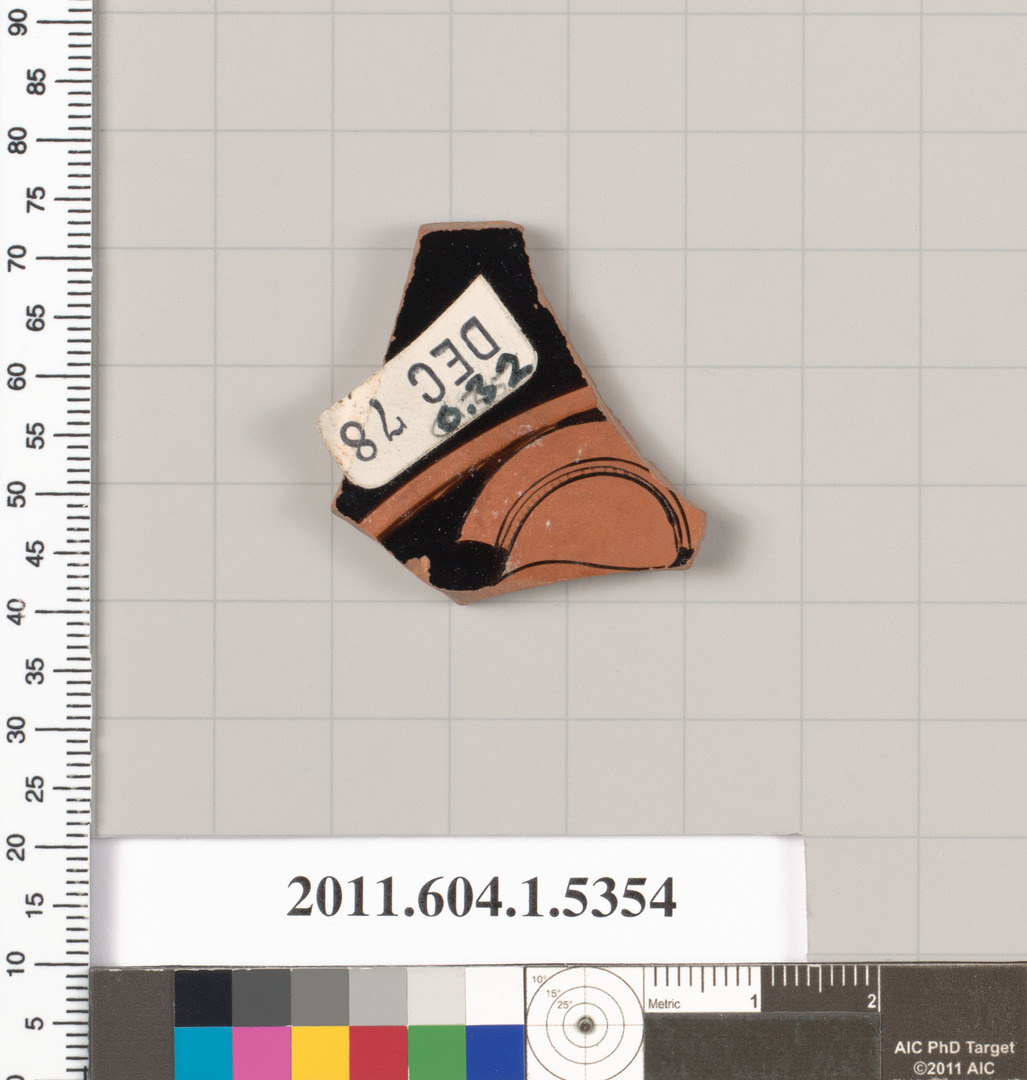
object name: kylix fragment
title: Terracotta fragment of a kylix (drinking cup)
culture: greek, attic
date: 520-500 BCE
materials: terracotta